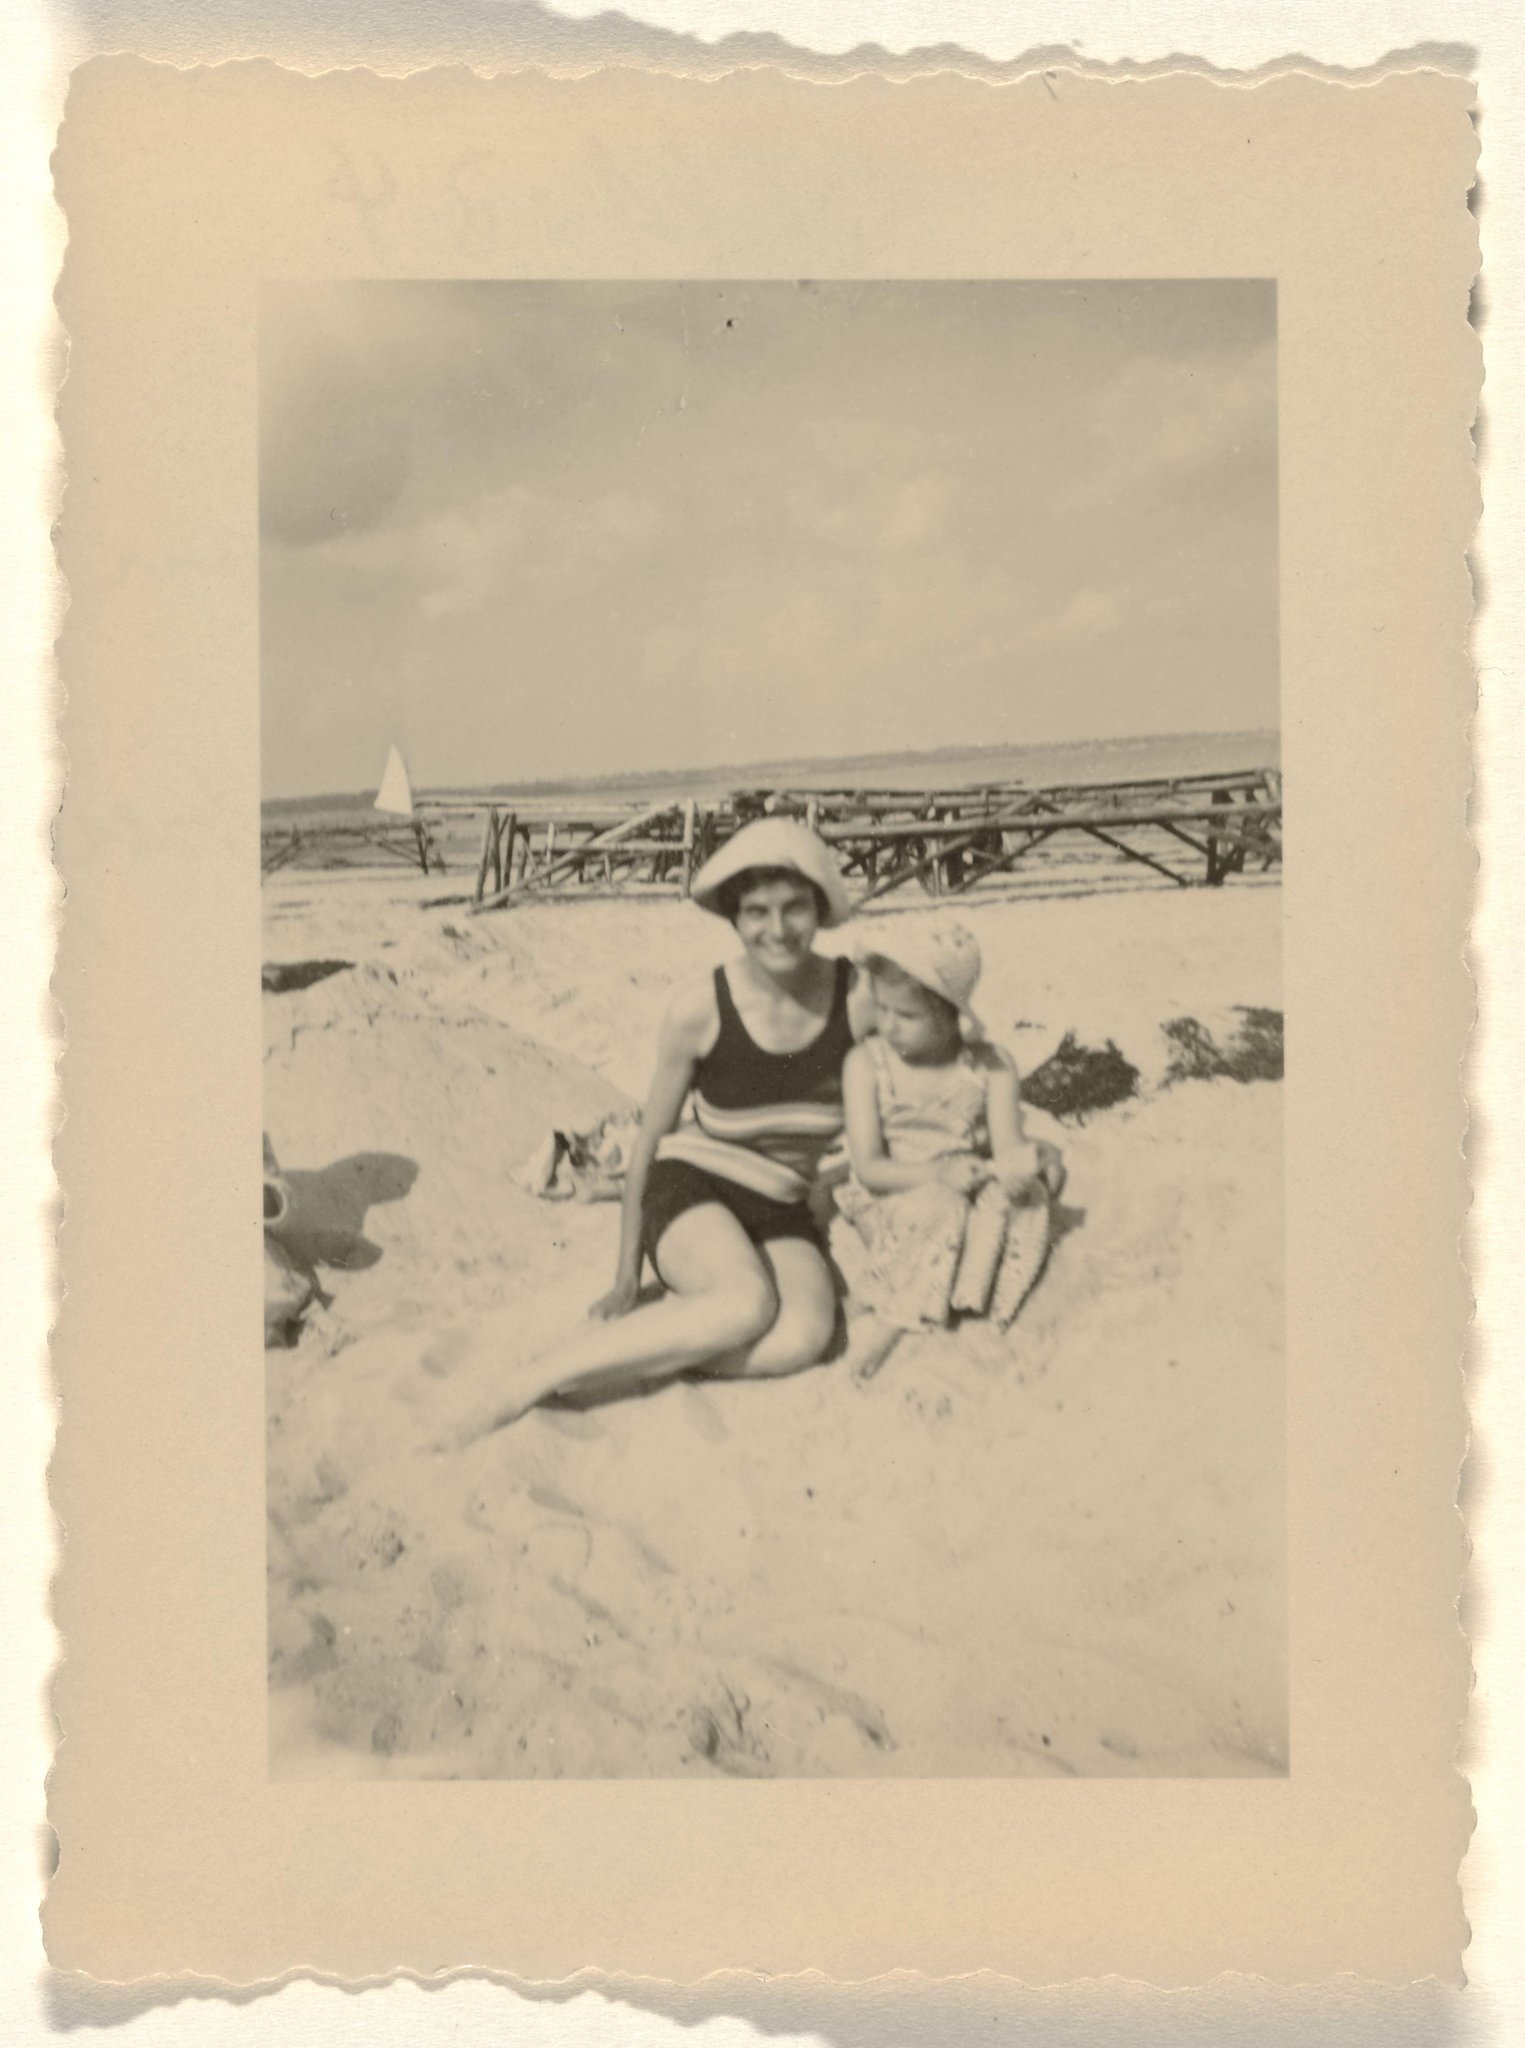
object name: photograph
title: Isabel Wachenheimer op strand van Scharbeutz, september 1934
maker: Anonymous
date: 1909-1934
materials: photographic support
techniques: gelatin silver print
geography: scharbeutz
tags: isabel wachenheimer-elon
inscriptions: date: ‘Sept.34. am Strand von Scharbeutz(Ostsee)’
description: Dit object is onderdeel van de nalatenschap van Isabel Elon-Wachenheimer (1928-2010). Tot haar overlijden behoorde het samen met de andere objecten uit de nalatenschap tot haar privédomein van Isabel Wachenheimer. In die particuliere context zijn deze objecten tezamen en individueel aandenkens - aan de jeugd, ouders en familie van Isabel Wachenheimer vóór en tijdens de Shoah en aan haar leven na de Tweede Wereldoorlog. Isabel Wachenheimer, die van juni 1943 tot mei 1945 gevangen zat in Kamp Westerbork, Theresienstadt, Auschwitz, Lenzing a/d Oberdonau (een buitenkamp van Mauthausen), overleefde de Shoah. Haar ouders – Eugène Wachenheimer en Else Wachenheimer-Moos - werden op 14 oktober 1944 in Auschwitz-Birkenau vermoord.